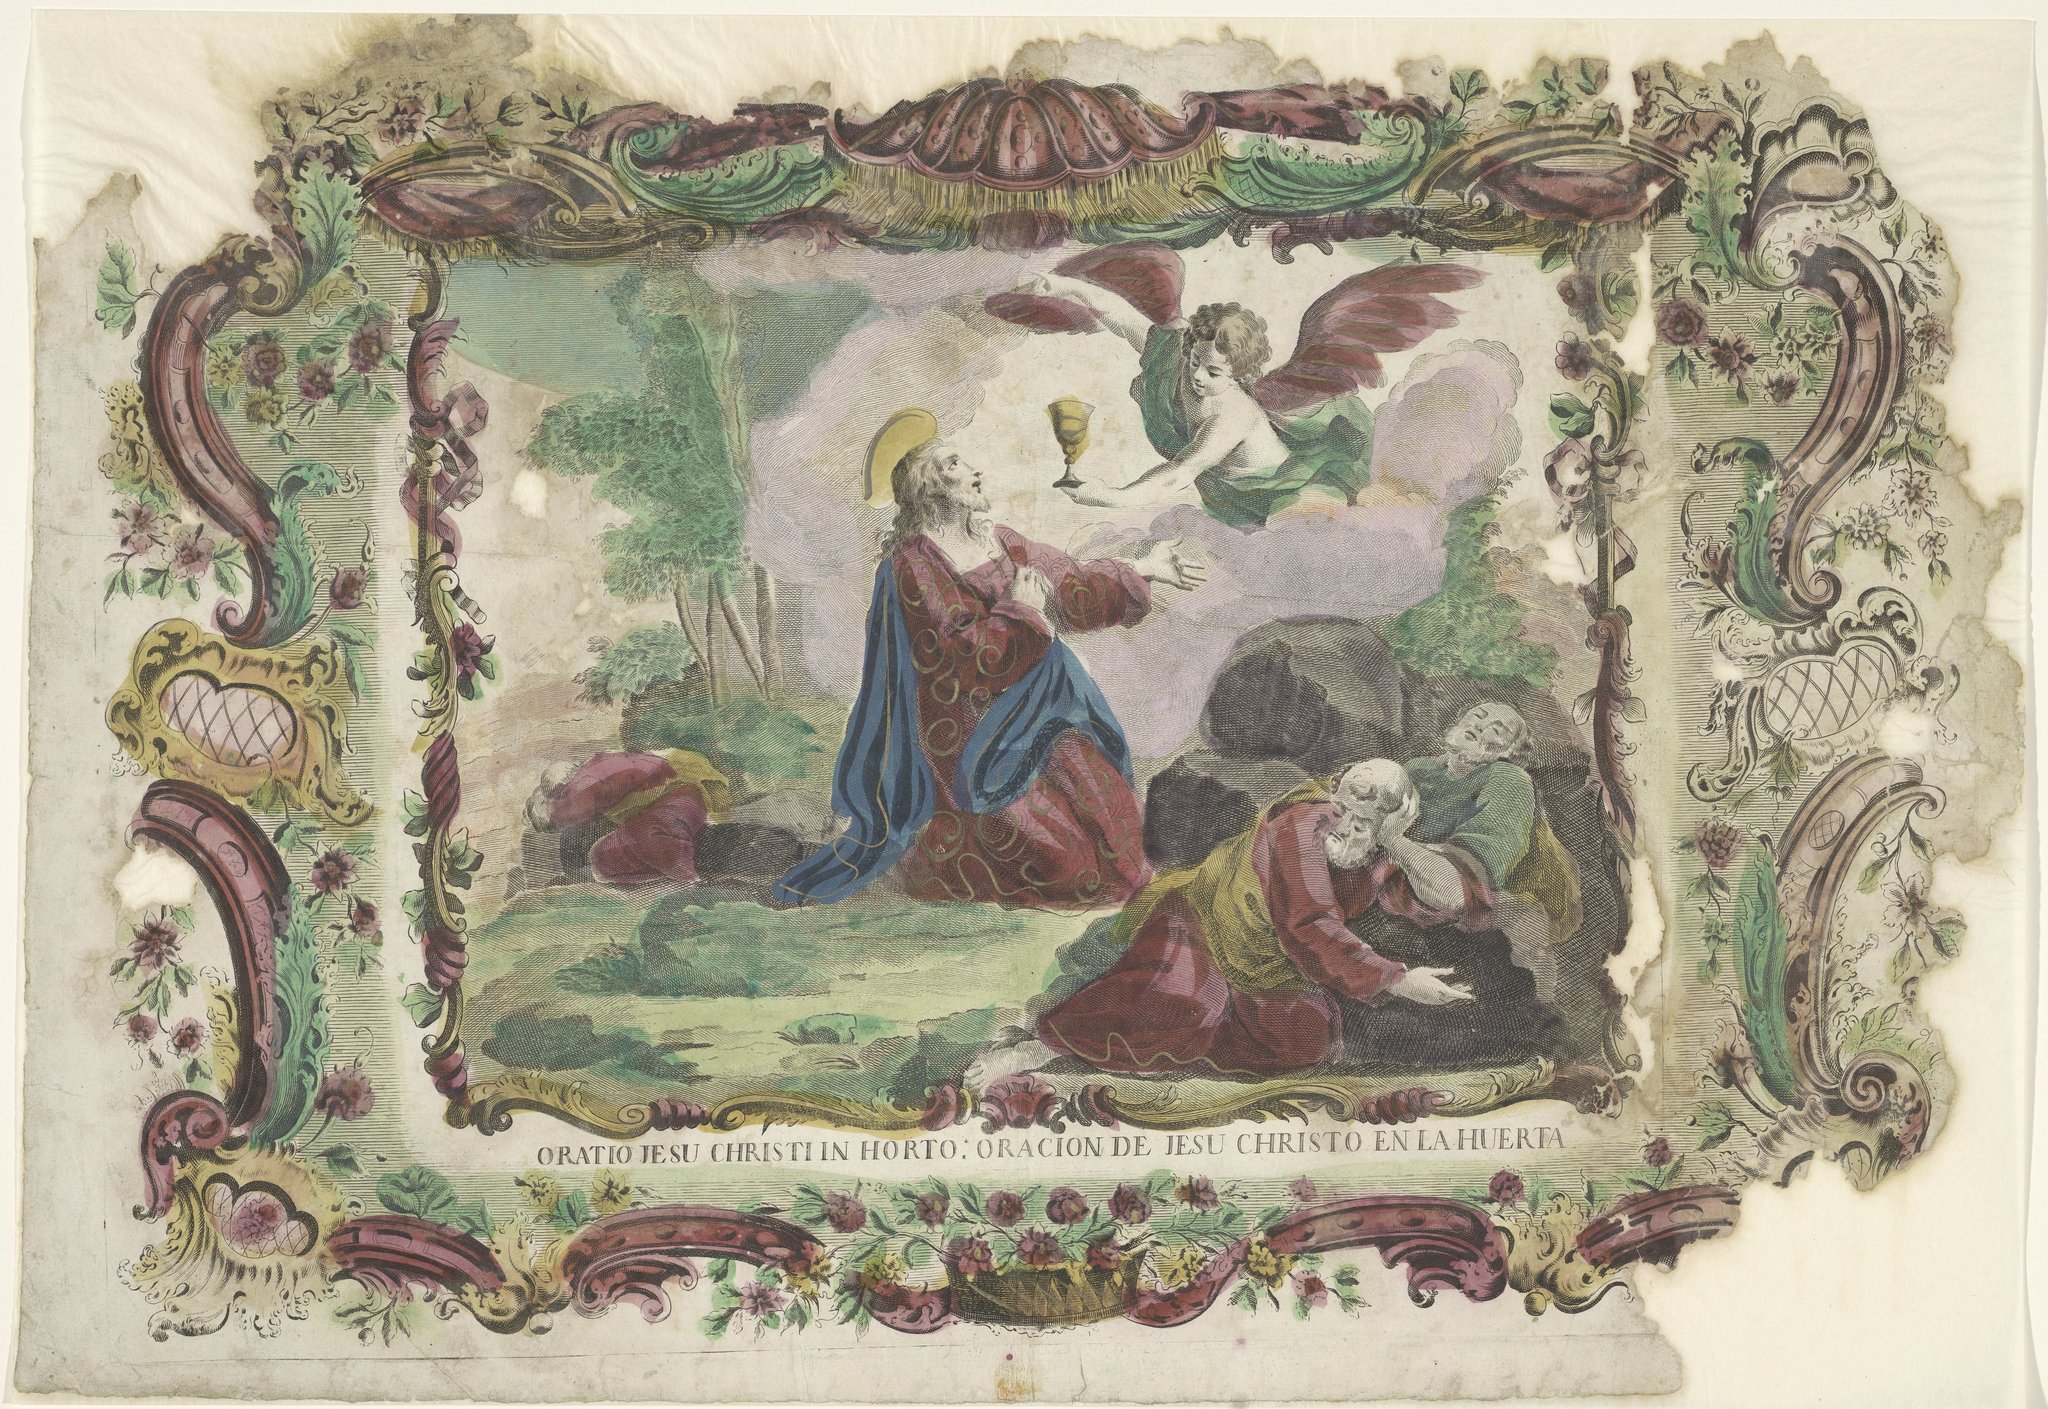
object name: print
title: Christus in de hof van Getsemane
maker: giovanni volpato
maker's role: ceramicist, print maker, printer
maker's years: 1735-1803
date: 1700-1799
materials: paper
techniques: colour, engraving, etching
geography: italy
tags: ornaments ~ art, agony of christ: to comfort him one or more angels appear to christ with chalice and/or cross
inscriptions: collector's mark: Lugt 2760, collector's mark: Lugt 2228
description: Christus bidt voor zijn leerlingen op de olijfberg en wordt door een engel met een kelk bezocht. Rechtsvoor twee slapende apostelen. Linksachter een derde slapende apostel. Titel in twee talen onder de voorstelling. De scène is gevat in een ornamentrand.